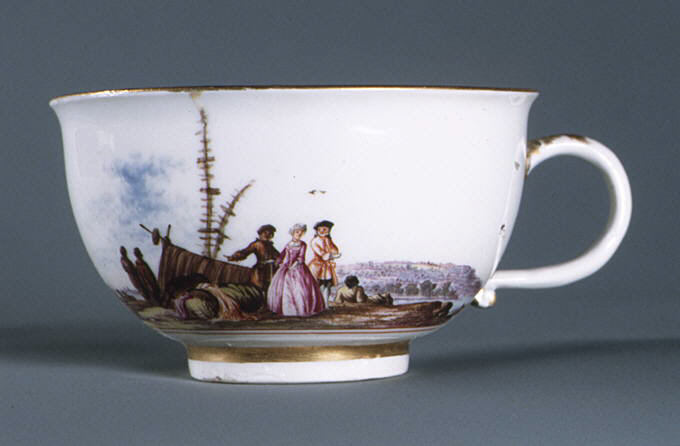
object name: cup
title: Cup (part of a service)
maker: meissen manufactory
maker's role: manufactory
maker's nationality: german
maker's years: 1710-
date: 1701-1800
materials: hard paste porcelain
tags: men,women